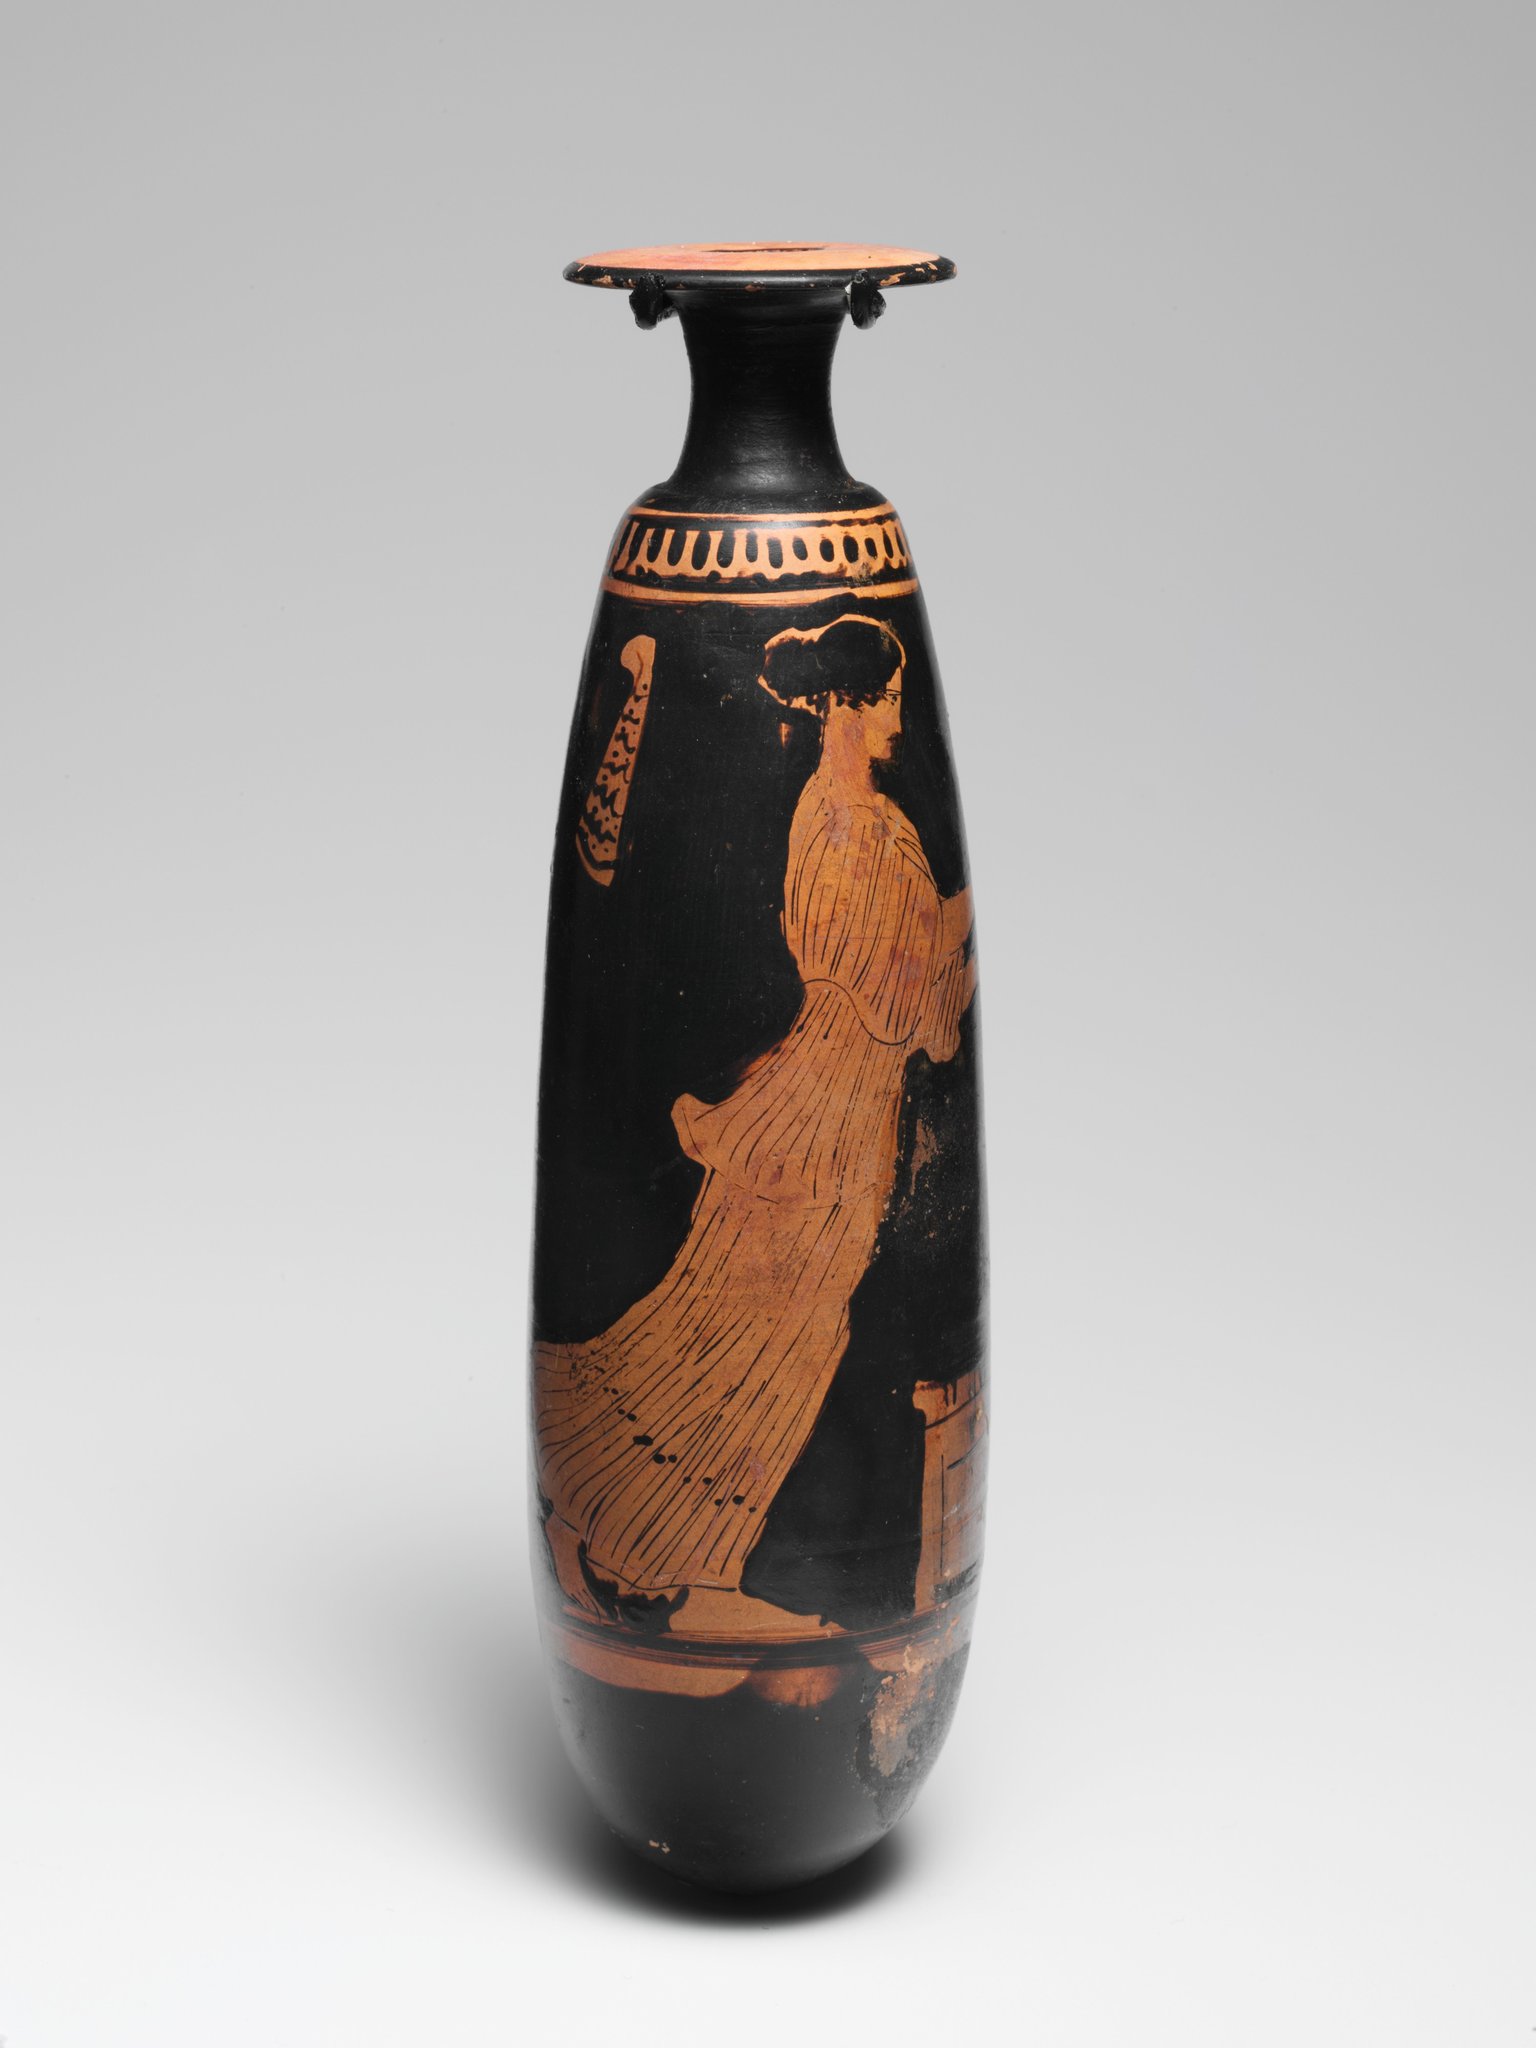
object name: alabastron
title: Terracotta alabastron (perfume vase)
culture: greek, attic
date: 440-430 BCE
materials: terracotta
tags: women